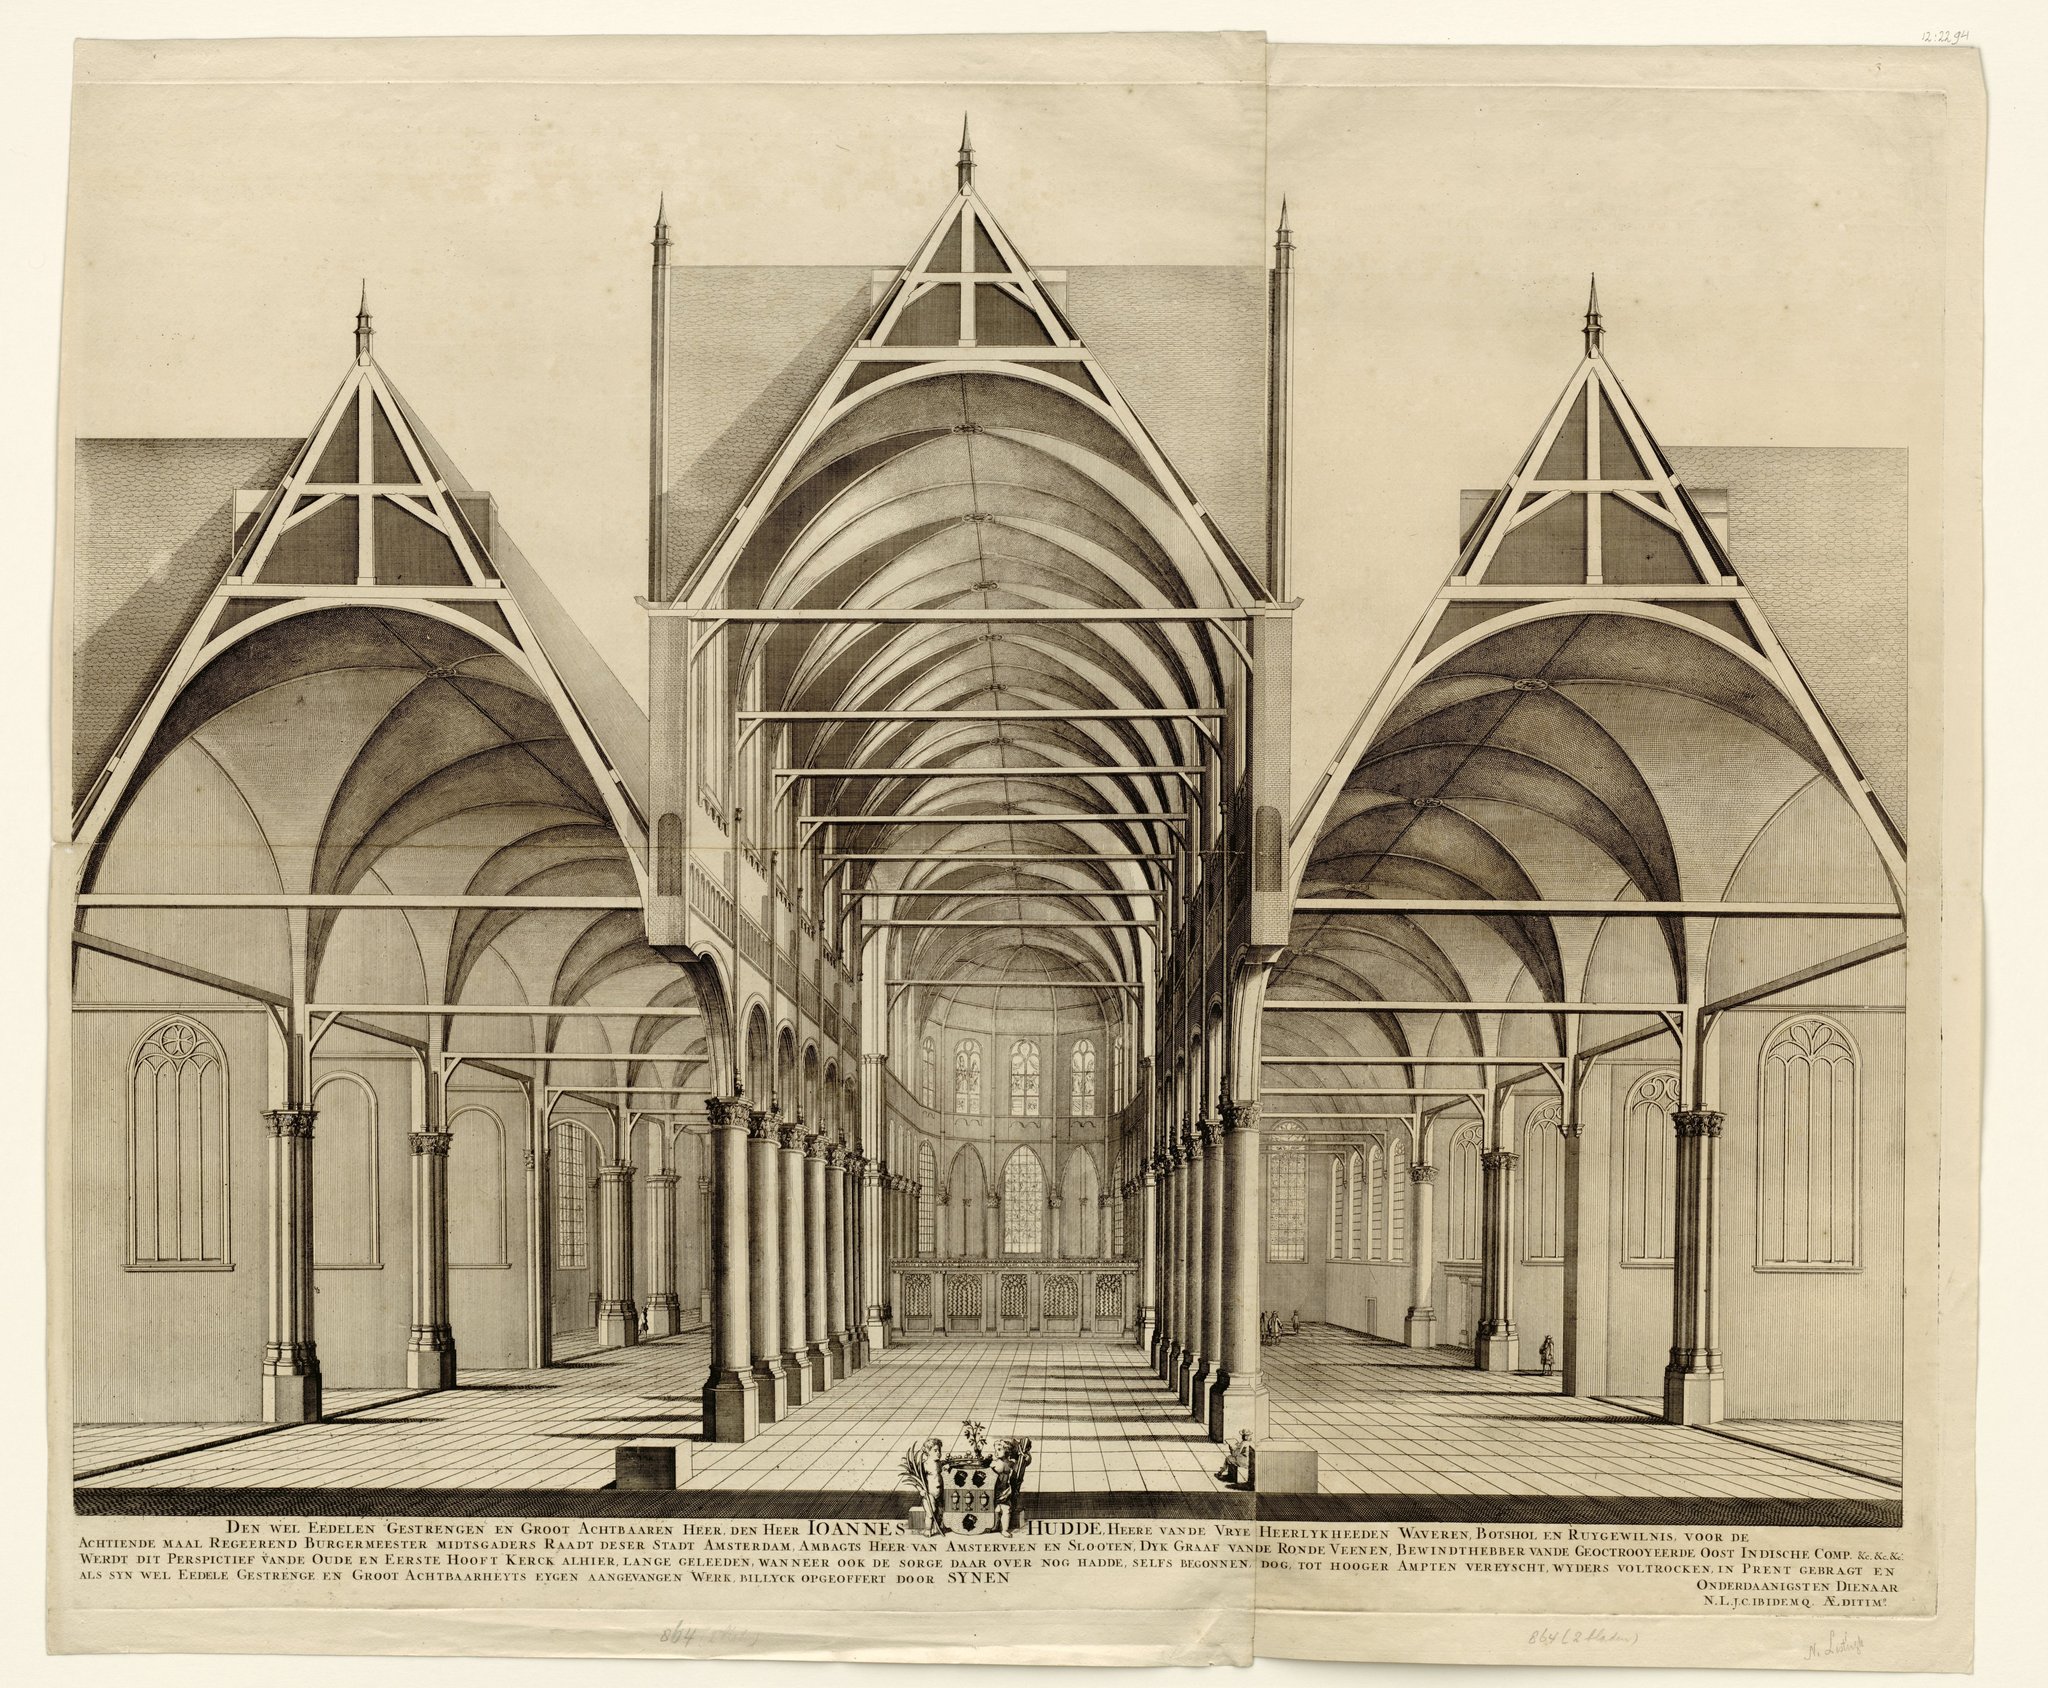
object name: print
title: Perspictief vande Oude en Eerste Hooft Kerck alhier (...)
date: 1699-1704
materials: paper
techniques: etching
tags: interior of church